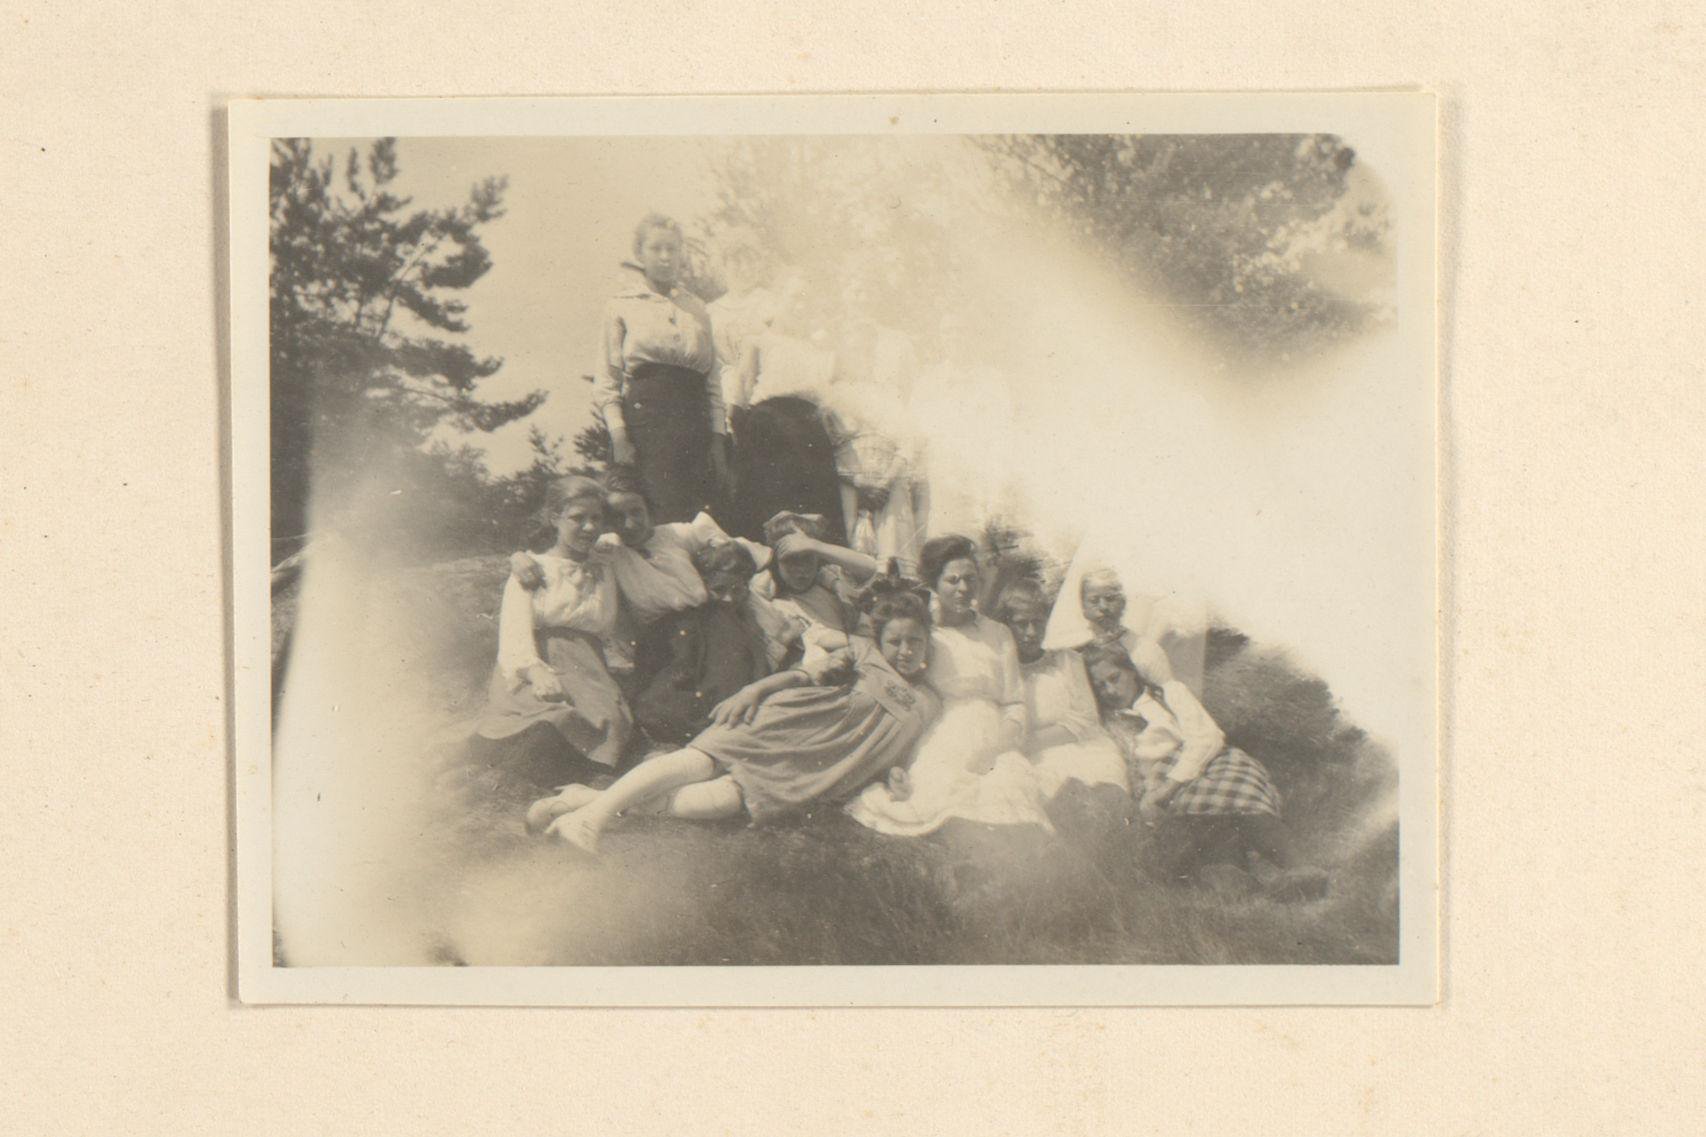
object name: album leaf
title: Vrouw met twee honden en een man, zittend op een decorstuk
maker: liesbeth overhoff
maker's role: fotograaf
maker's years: 1895-1969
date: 1915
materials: paper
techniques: gelatin silver print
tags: adult woman, backdrop, adult man